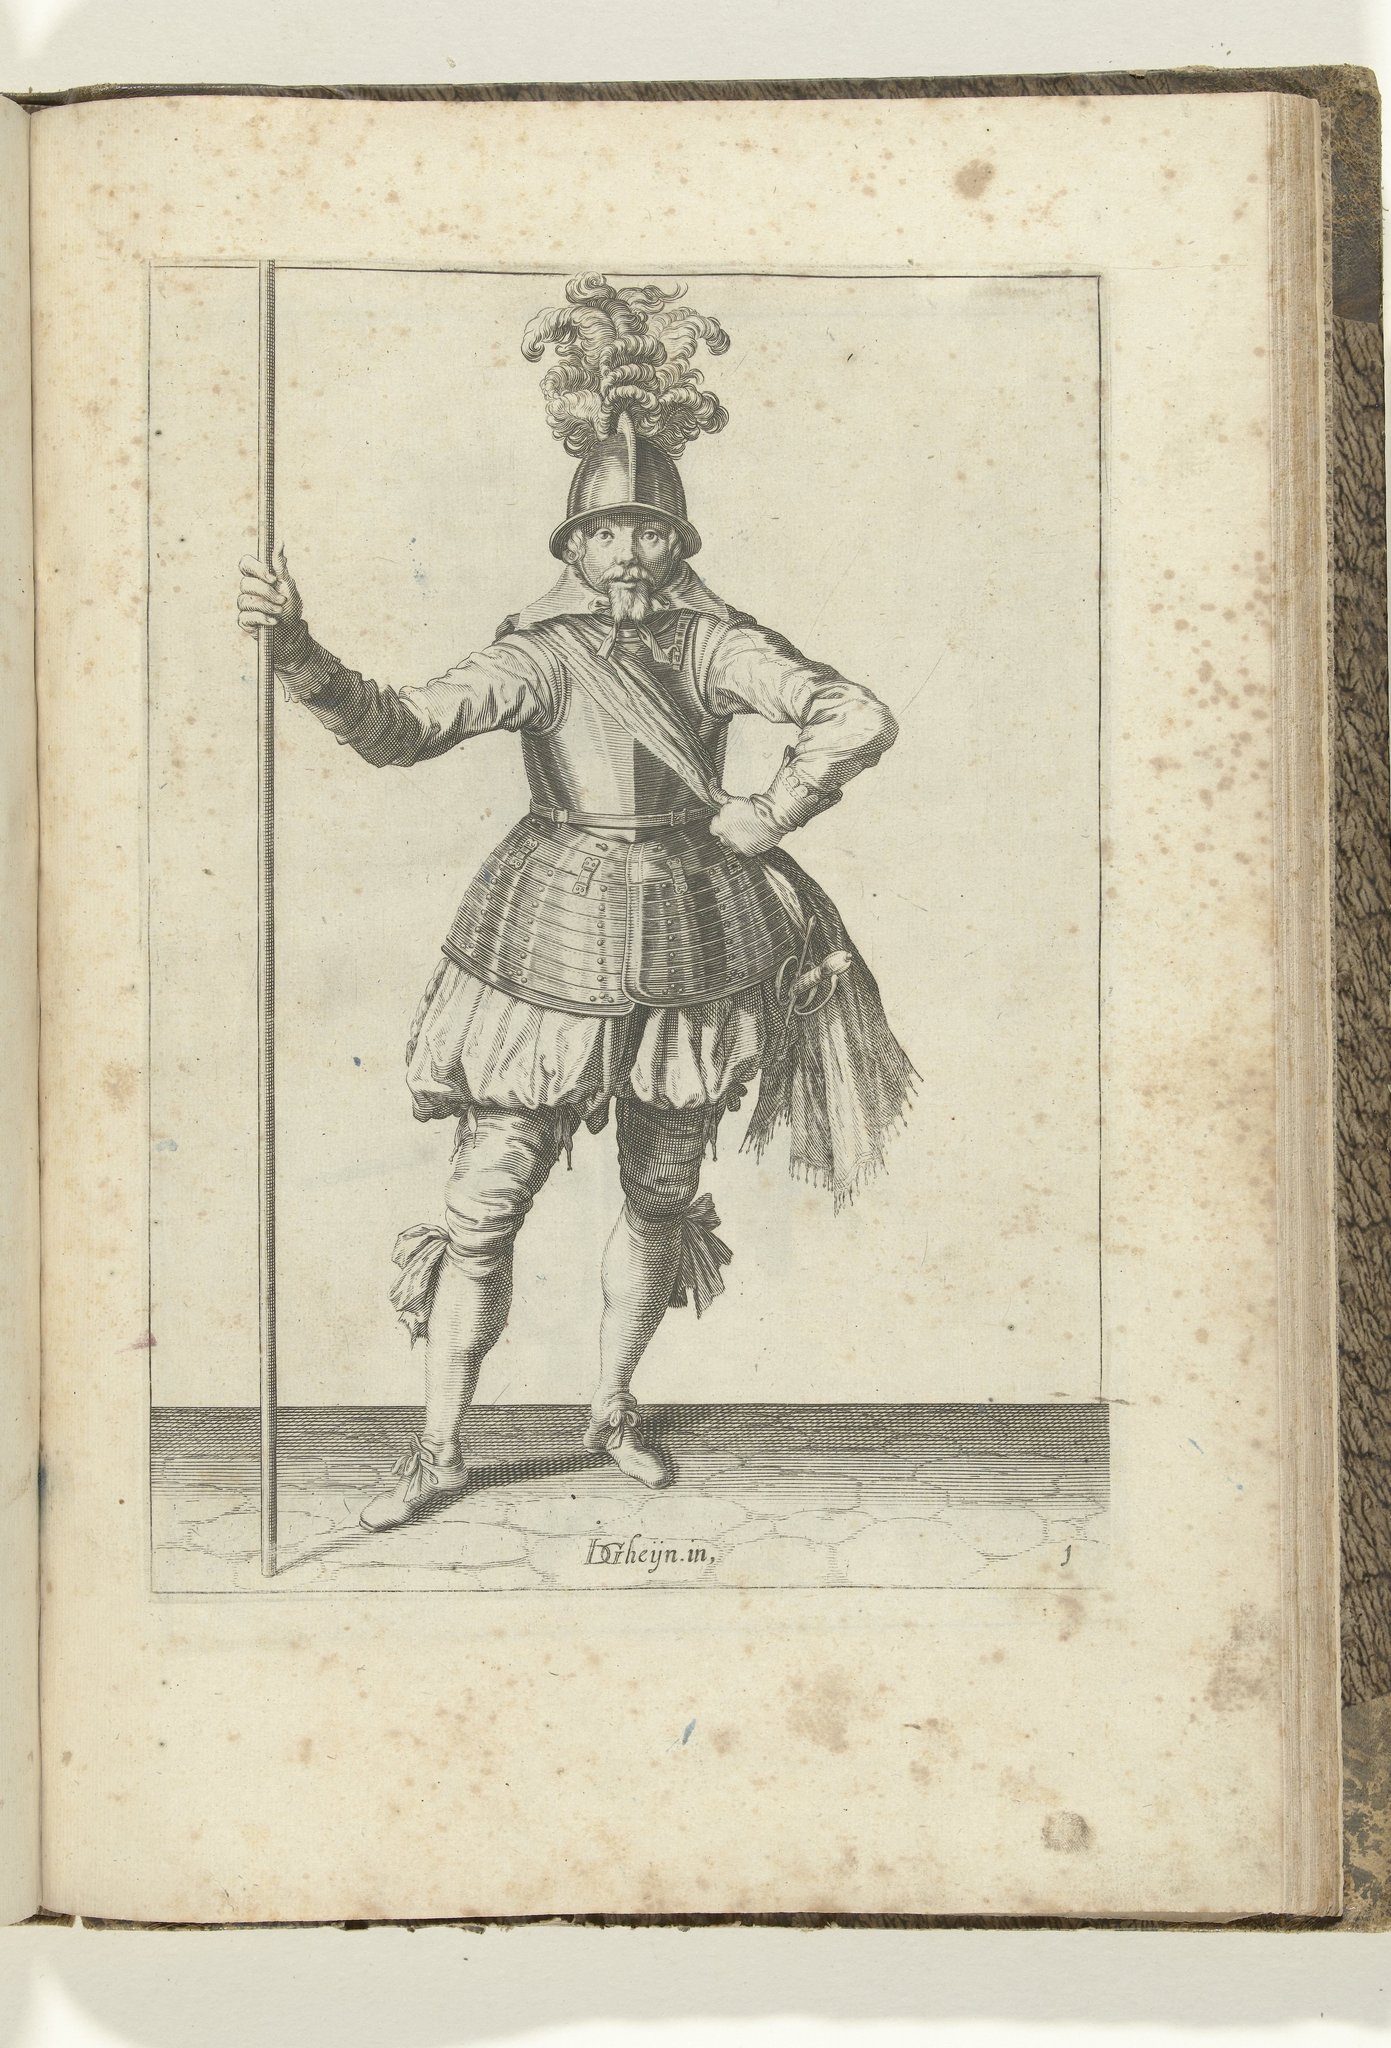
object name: print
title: Soldaat, van voren gezien, die zijn spies met zijn rechterhand rechtop vasthoudt (nr. 1), ca. 1600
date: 1597-1608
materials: paper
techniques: engraving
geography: northern netherlands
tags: maurice (prince of orange), handling of weapons ~ military training, weapons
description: Een soldaat, ten voeten uit, die een spies (lans) met zijn rechterhand rechtop vasthoudt (nr. 1), ca. 1600. Plaat 1 in de instructies voor het hanteren van de spies: Enseignement brief; et succint sur les portraitz figurez, touchant l'usage, de tout ce qu'un Soldat doibt faire au maniement de la Pique. Onderdeel van de illustraties in een Franse editie van J. de Gheyns Wapenhandelinghe: J. de Gheyn, Maniement d'armes, d'arquebuses, mousquetz et piques : en conformité de l'ordre de Mour le Prince Maurice, Prince d'Orange, Amsterdam 1608. Krijgswezen rond 1600.